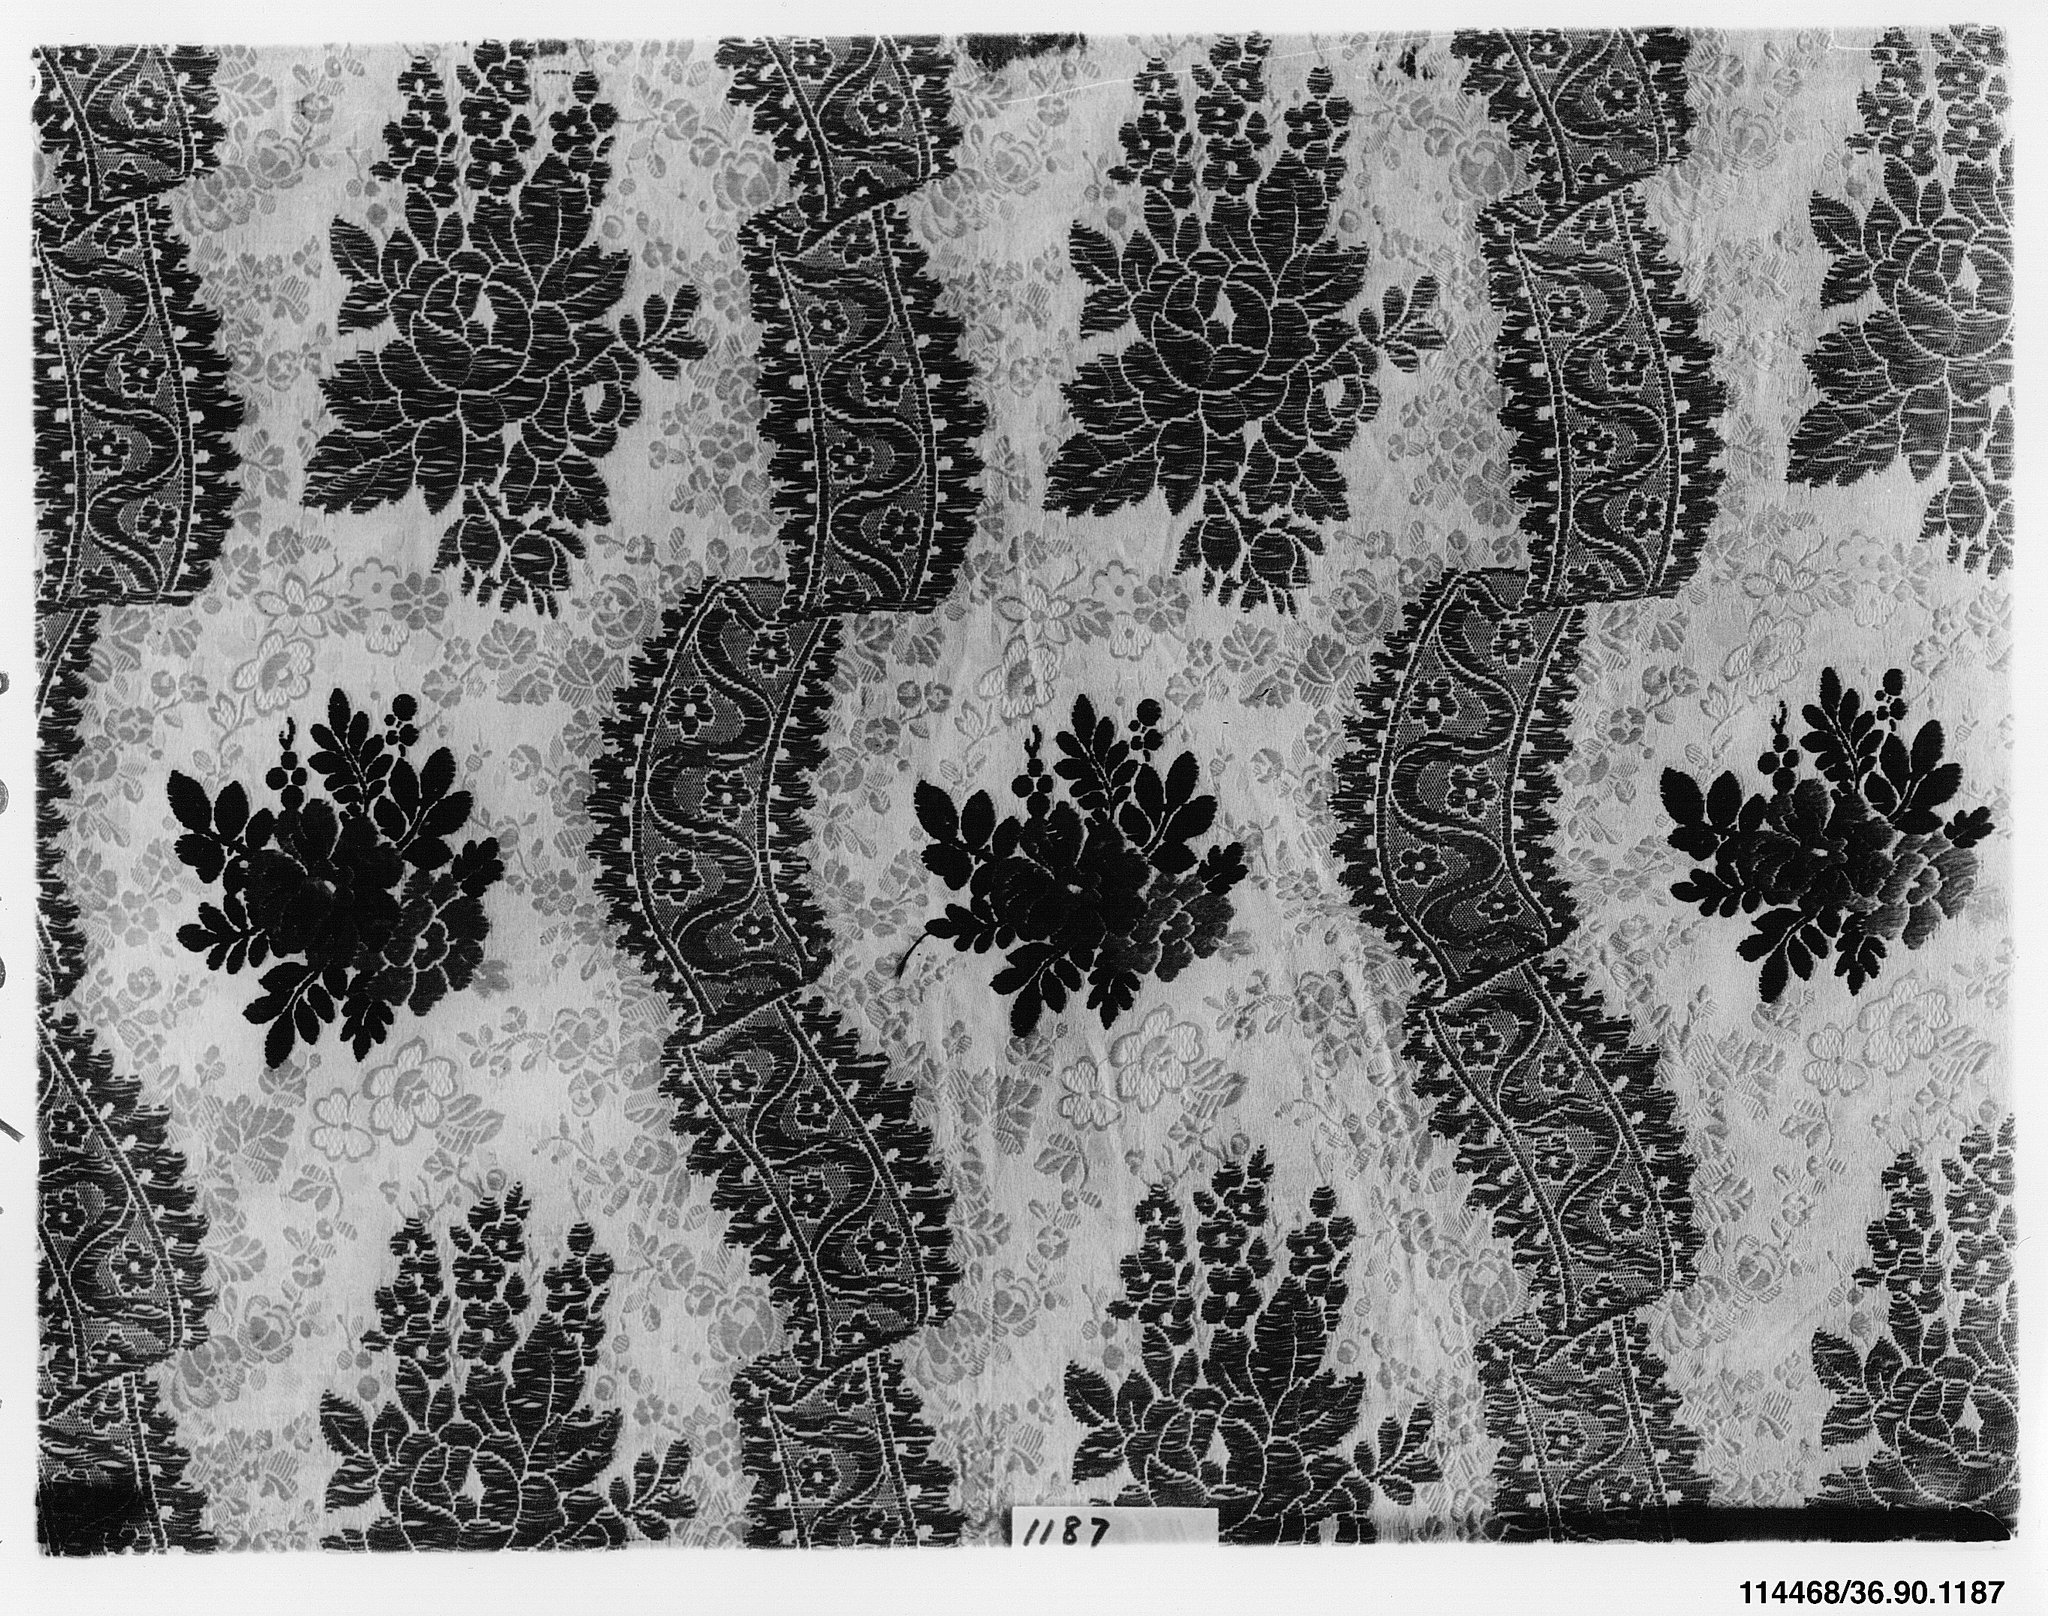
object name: piece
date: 1801-1900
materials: metal thread, silk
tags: flowers,leaves